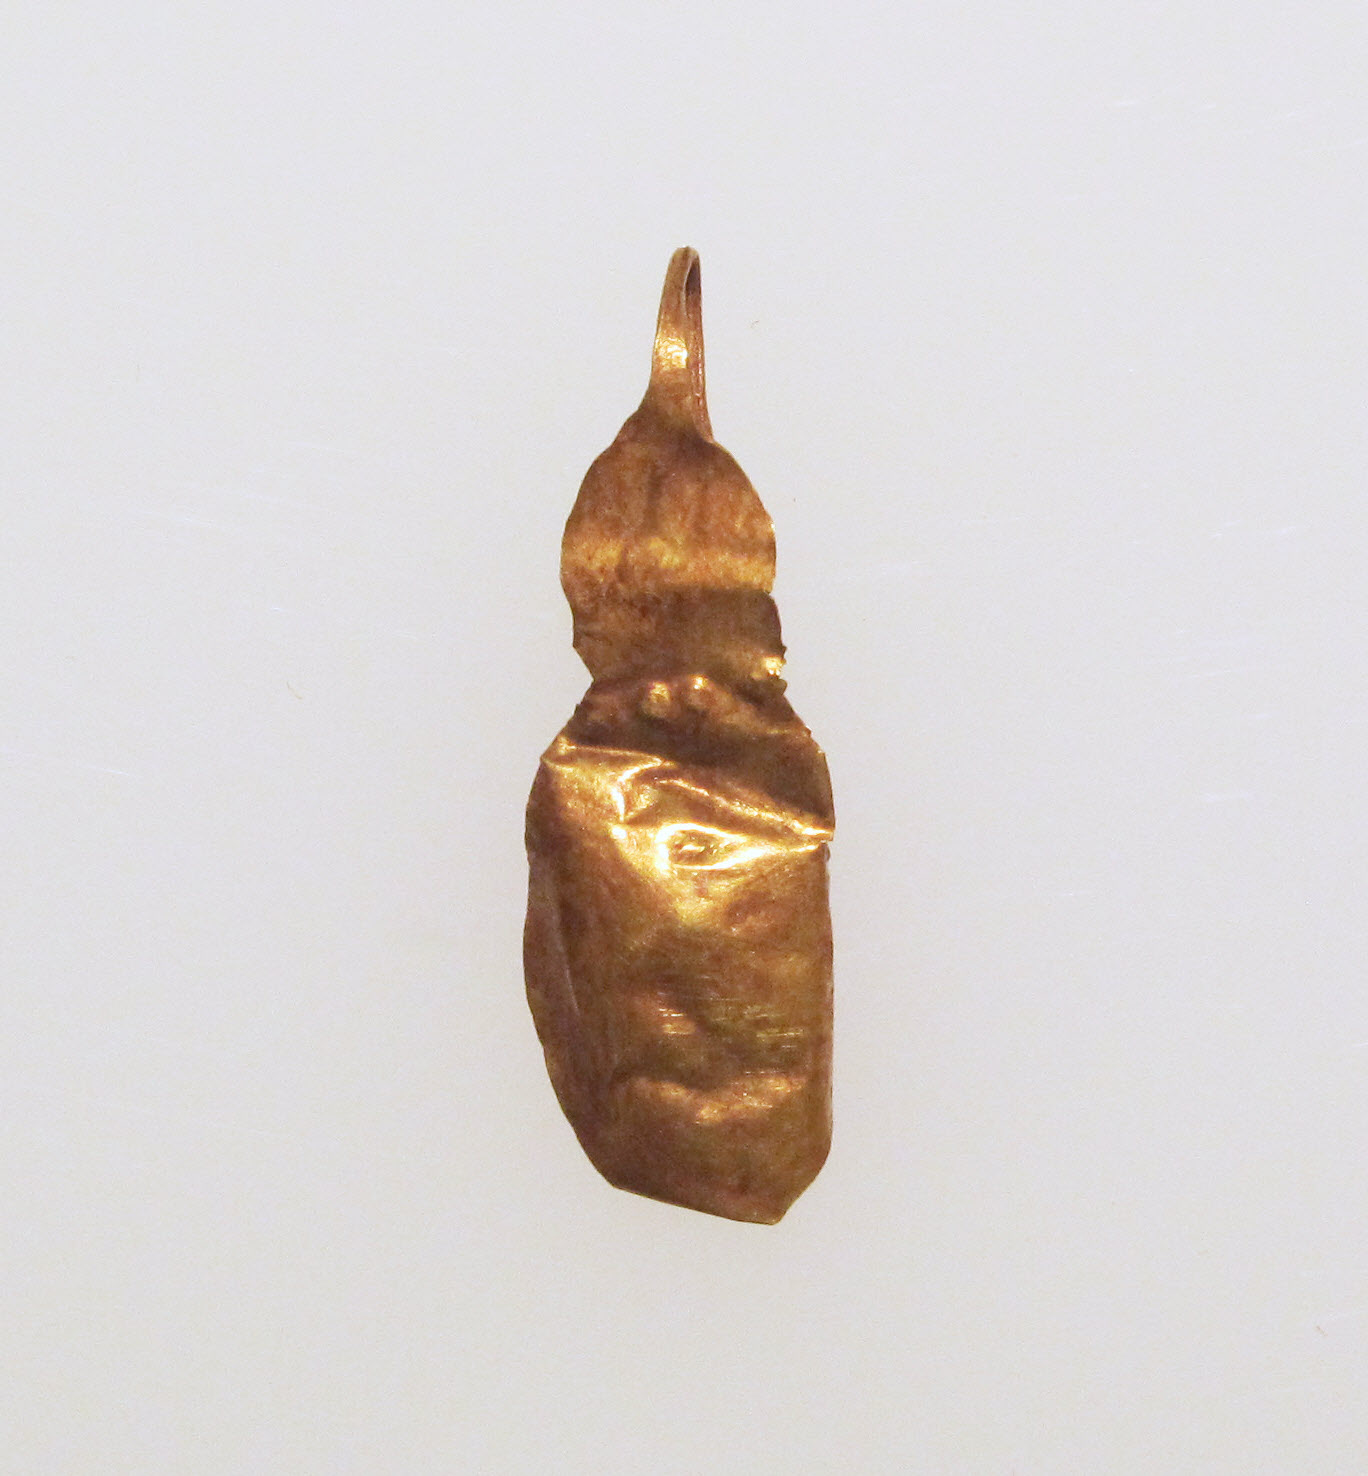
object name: earring hook type with leaf form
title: Earring-hook type with leaf form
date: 7000 BCE-330 CE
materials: gold